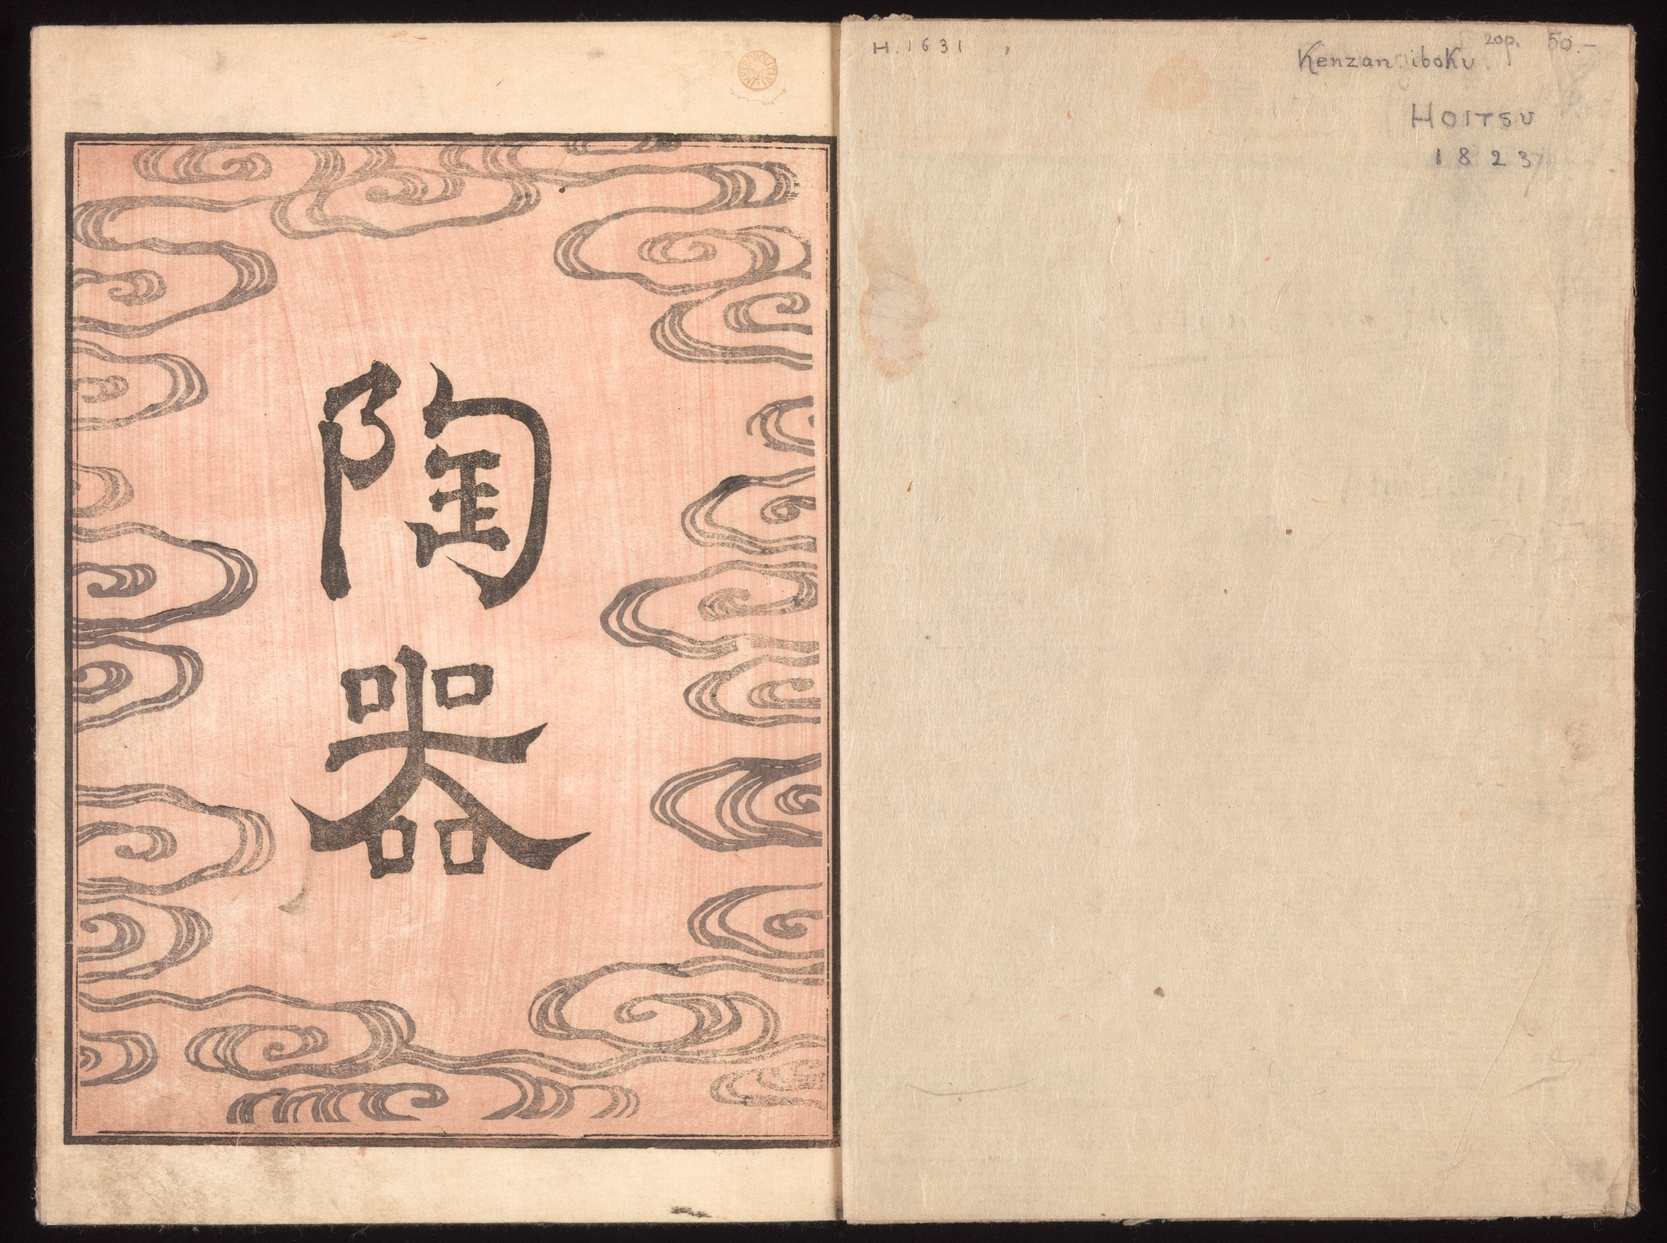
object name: illustrated book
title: Ink Traces of Kenzan (Kenzan iboku)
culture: japanese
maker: sakai hōitsu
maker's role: artist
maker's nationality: japanese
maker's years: 1761-1828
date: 1823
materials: ink, paper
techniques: woodblock print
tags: deer,flowers,leaves,trees